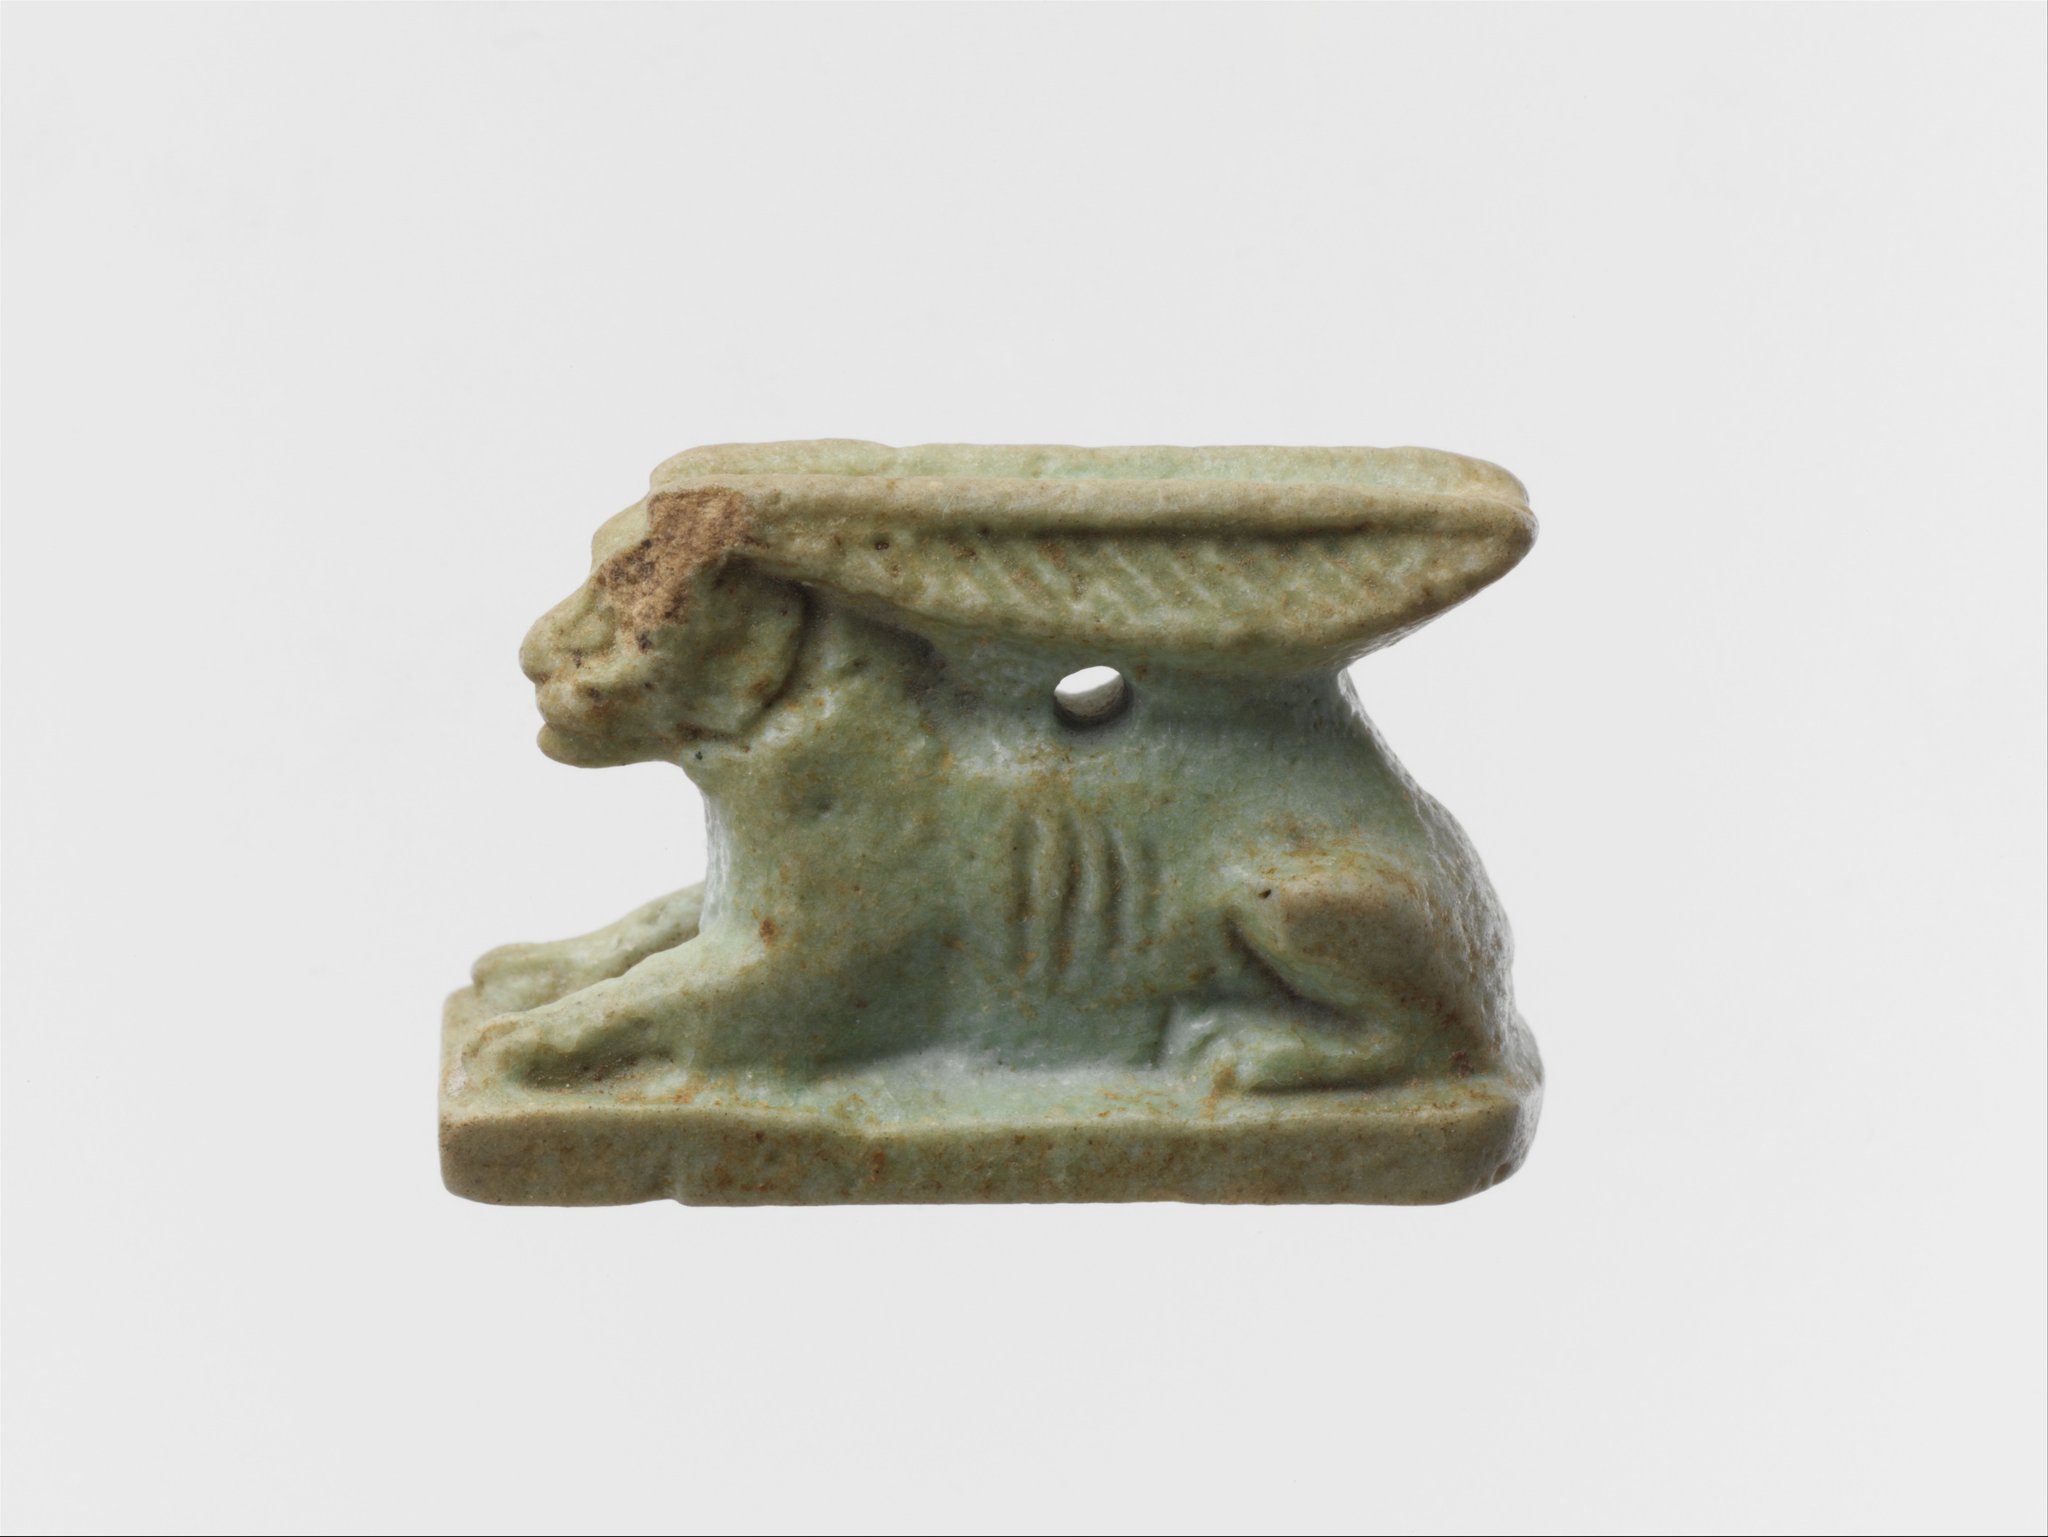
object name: amulet, hare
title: Faience amulet in the form of a hare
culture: egyptian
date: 664-630 BCE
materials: faience